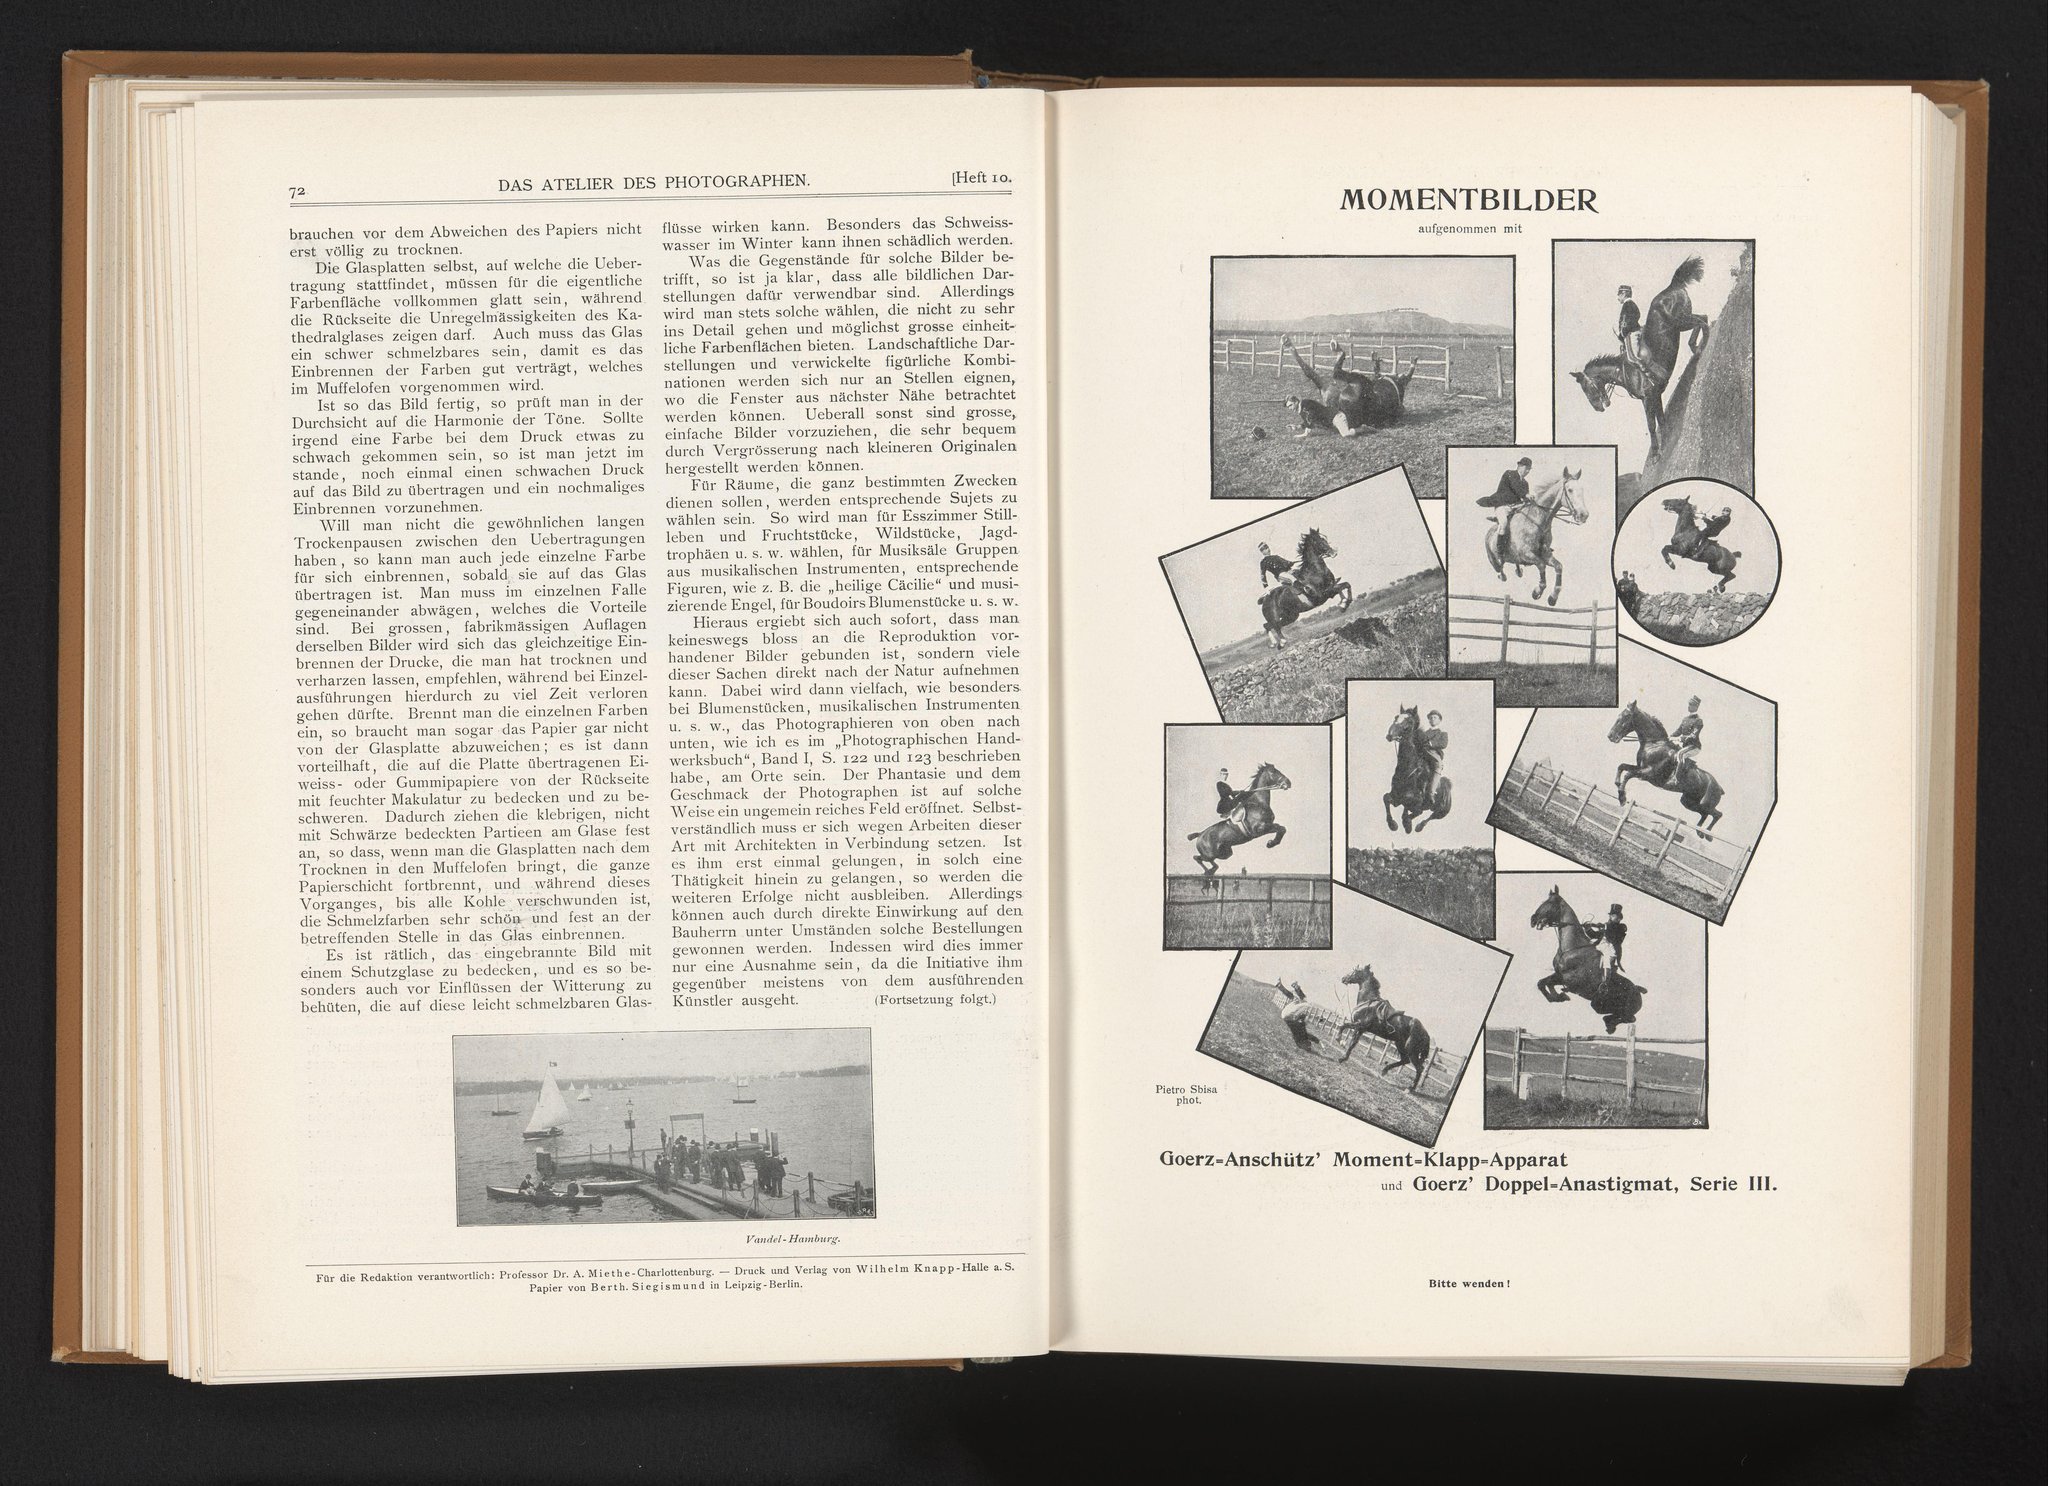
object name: page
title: Collage van acht afbeeldingen van springende paarden met ruiter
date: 1895-1900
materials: paper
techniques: autotype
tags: jumping (horse in motion)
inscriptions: inscription: ‘MOMENTBILDER/ aufgenommen mit/ Goerz-Anschütz' Moment=Klapp=Apparat/ und Goerz' Doppel=Anastigmat, Serie III./ Bitte wenden!’, monogram: ‘Bx’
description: Prenten tegenover pagina 72. Deze prenten maken deel uit van een reclameboodschap voor Goerz, een fabrikant van fotocamera's en lenzen.